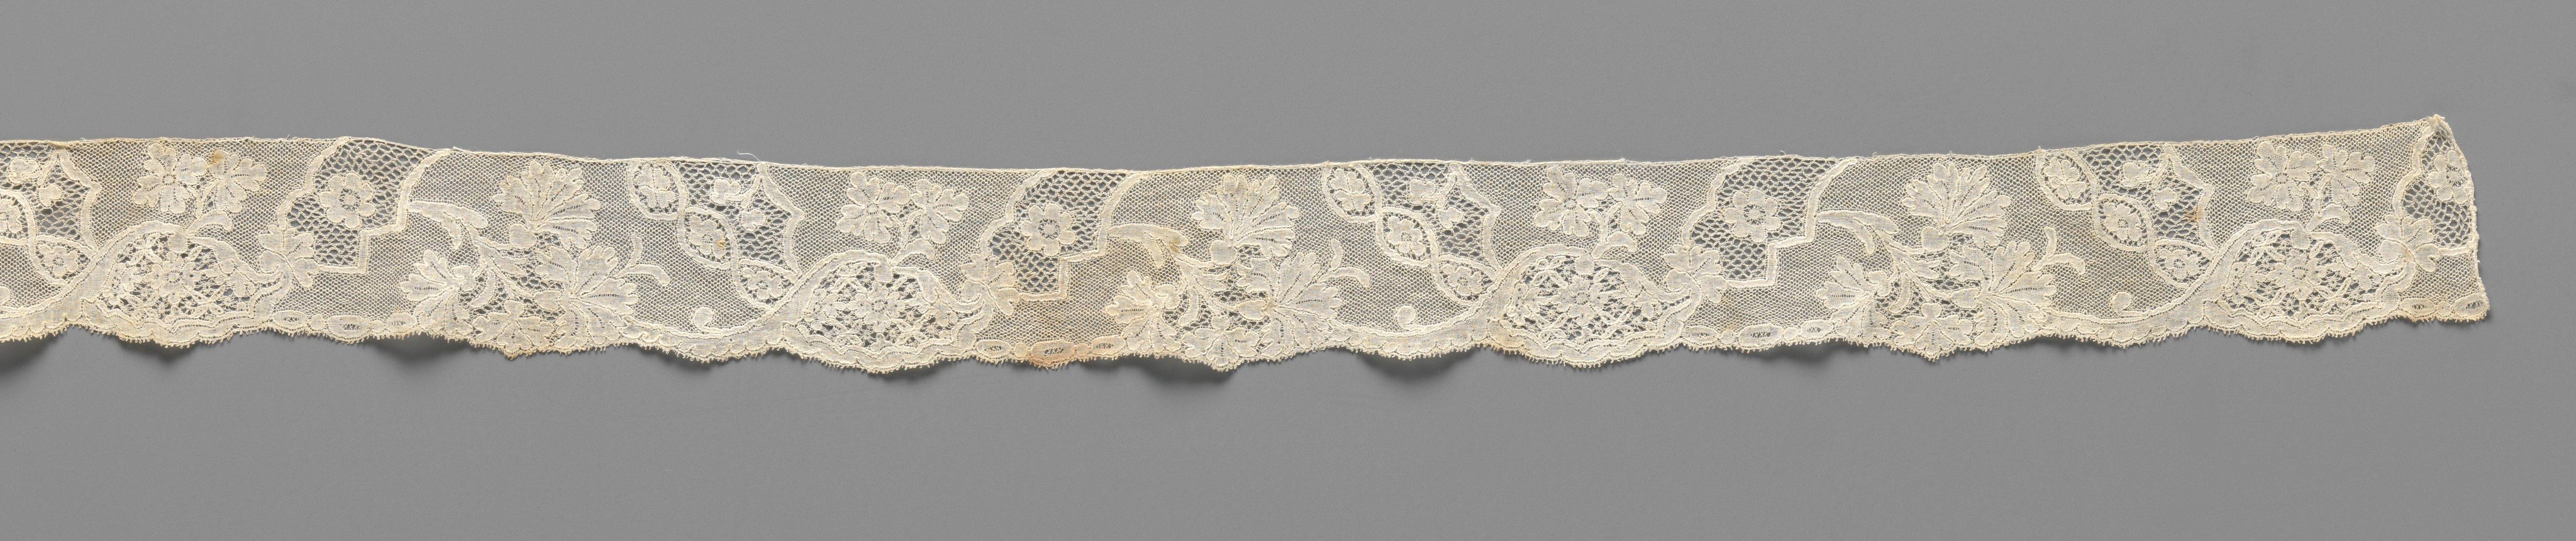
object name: strip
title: Strook kloskant met v-vormige compositie en anjers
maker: Anonymous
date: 1735-1765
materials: linen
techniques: lace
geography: mechelen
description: Strook naturelkleurige kloskant: Mechelse kant. Het zich herhalende patroon bestaat uit een v-vormige compositie gevormd door twee schuin geplaatste cartouches, die vanaf de bovenzijde van de strook aansluiten op een rocaille-achtig cartouche langs de onderzijde van de strook. Halverwege de rechter cartouche hangt een gebogen tak naar beneden met vier anjers die bijna de hele breedte van de strook vullen. De motieven zijn gemaakt in linnenslag met uitsparingen en voorzien van dikkere en glimmende contourdraden. De motieven zijn met elkaar verbonden door een fijne traliegrond, de Mechelse grond. Siergronden, voornamelijk rozengronden, zijn onder andere toegepast in de cartouches en tussen de anjers. De flauwe schulpenrand is afgewerkt met picots. De bovenzijde is recht afgewerkt.